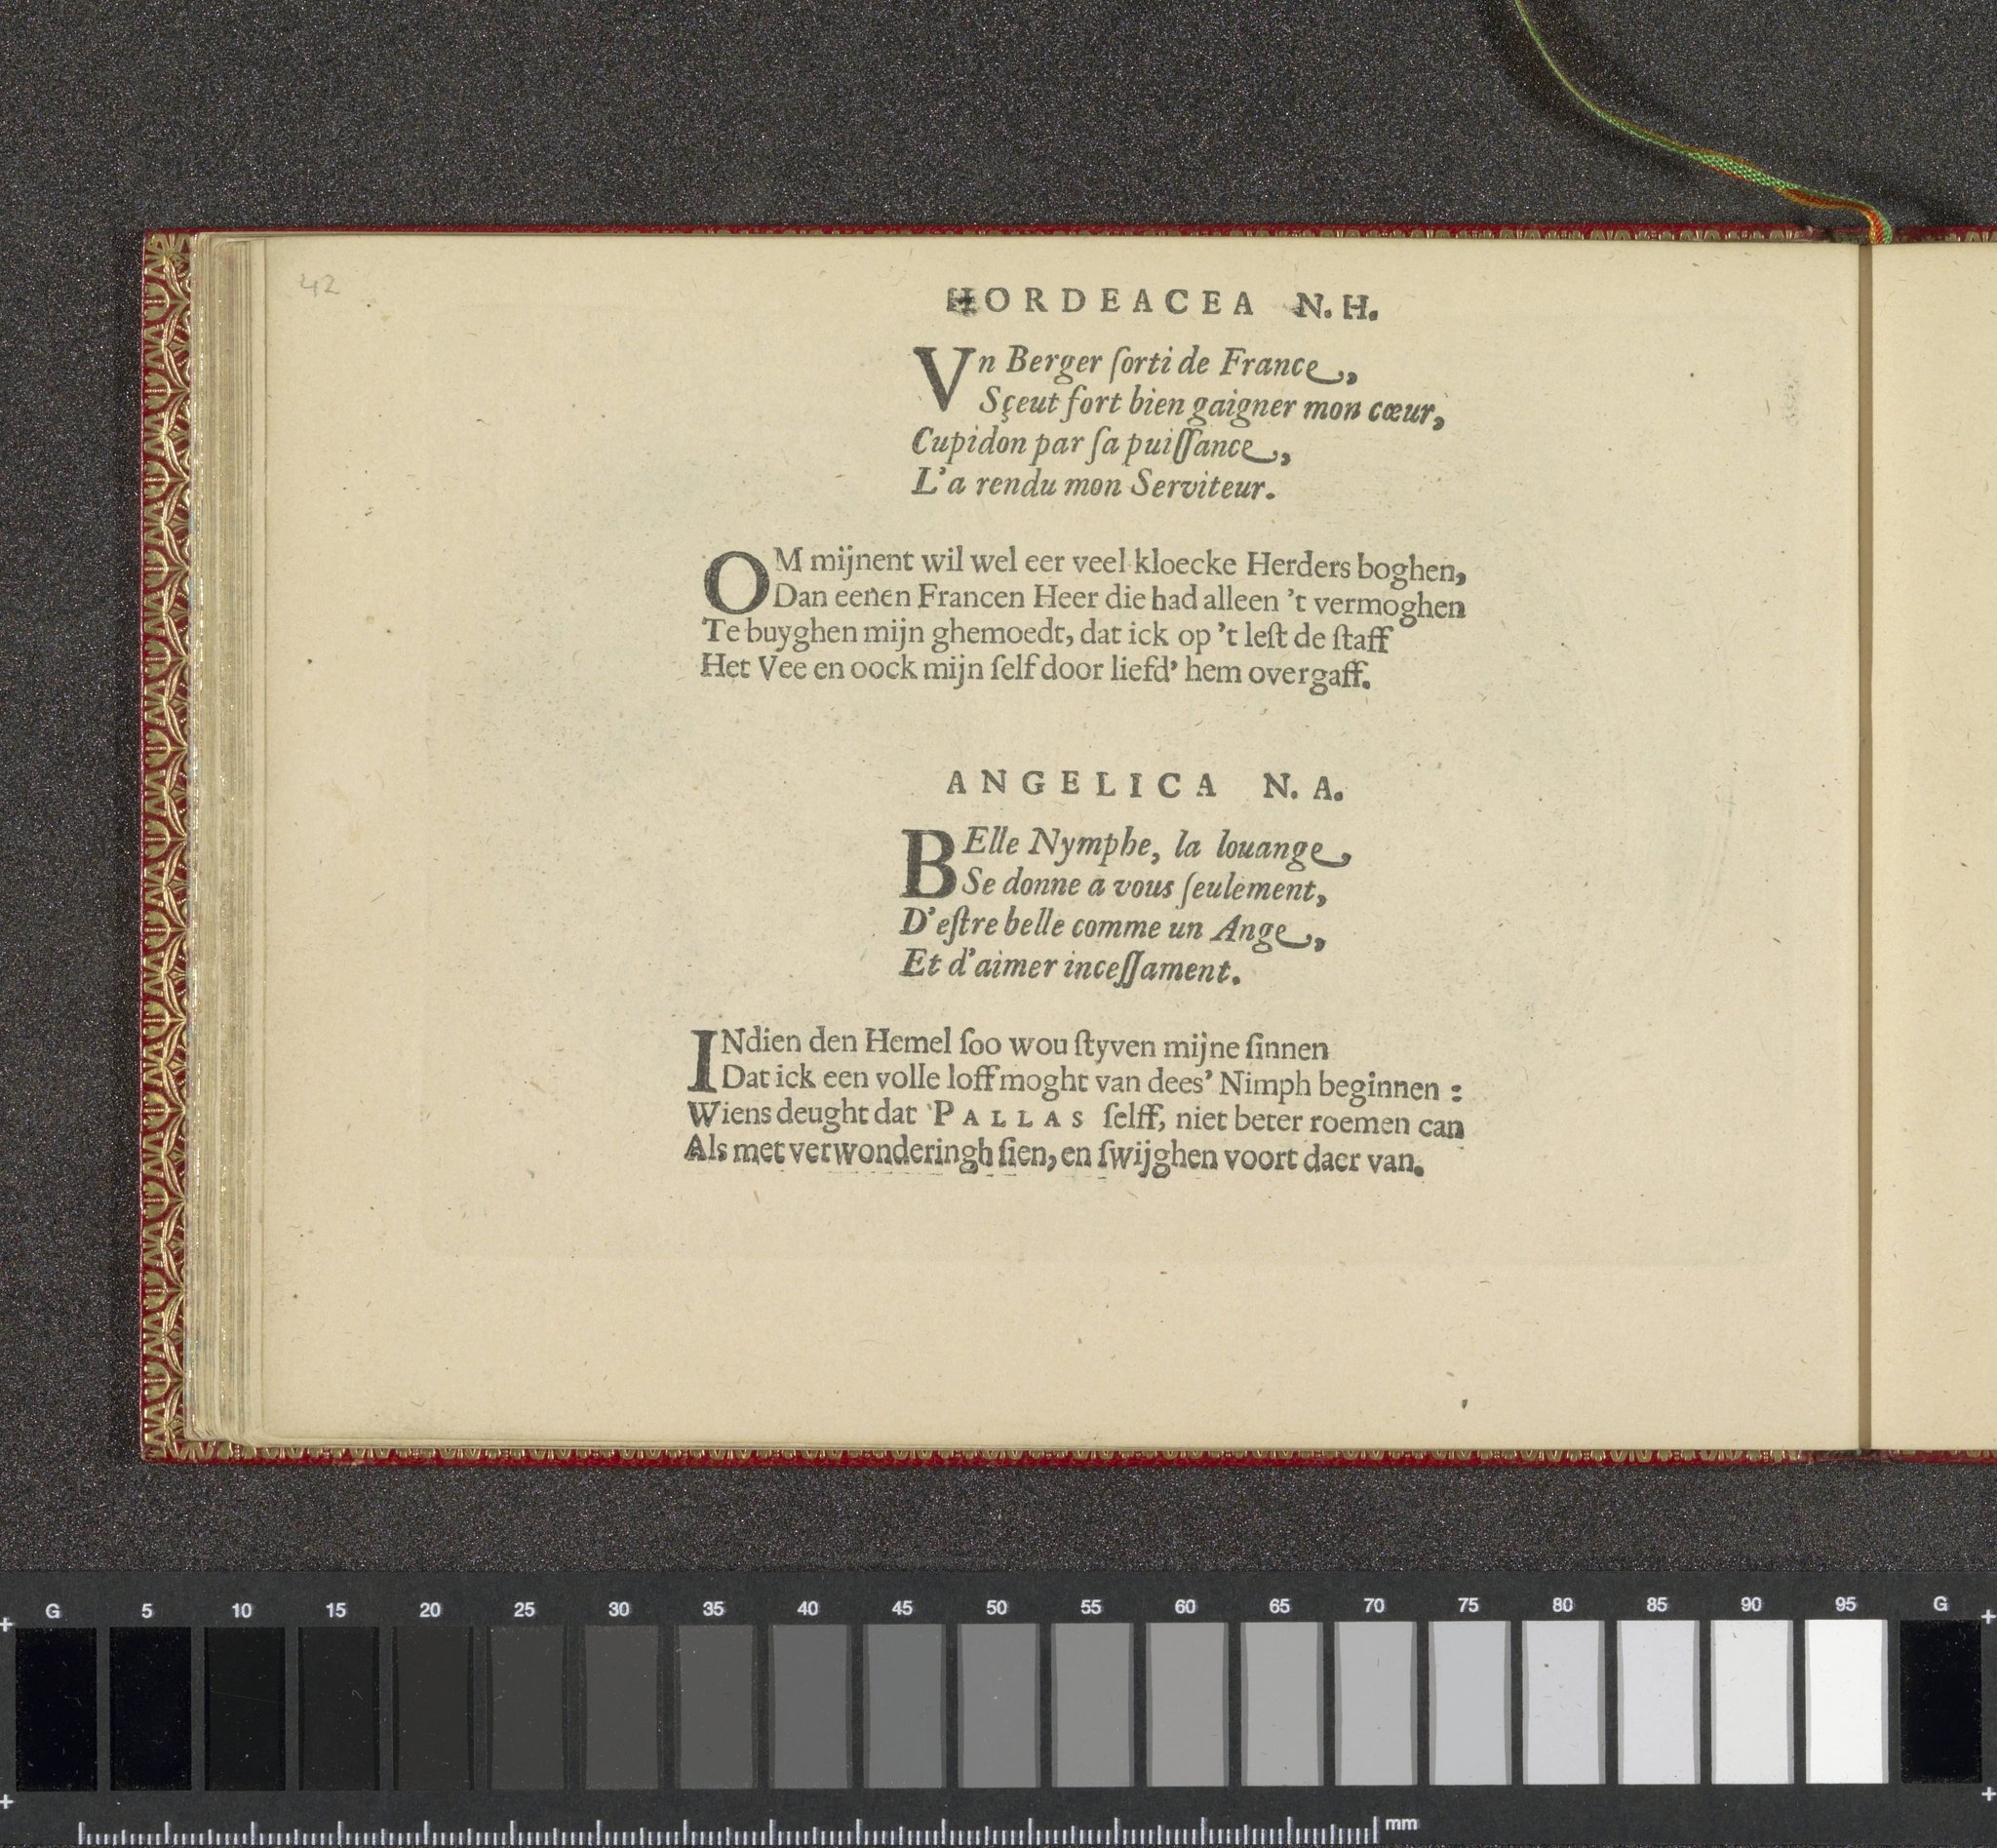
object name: album leaf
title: Les vrais pourtraits de quelques unes des plus grandes dames de la chrestiente desguisees en bergeres.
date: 1640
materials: paper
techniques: letterpress printing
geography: amsterdam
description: Twee keer twee kwatrijnen in het Frans en Nederlands bij de voorstellingen van Hordeacea N.H. en Angelica N.A. Het blad maakt deel uit van een album.